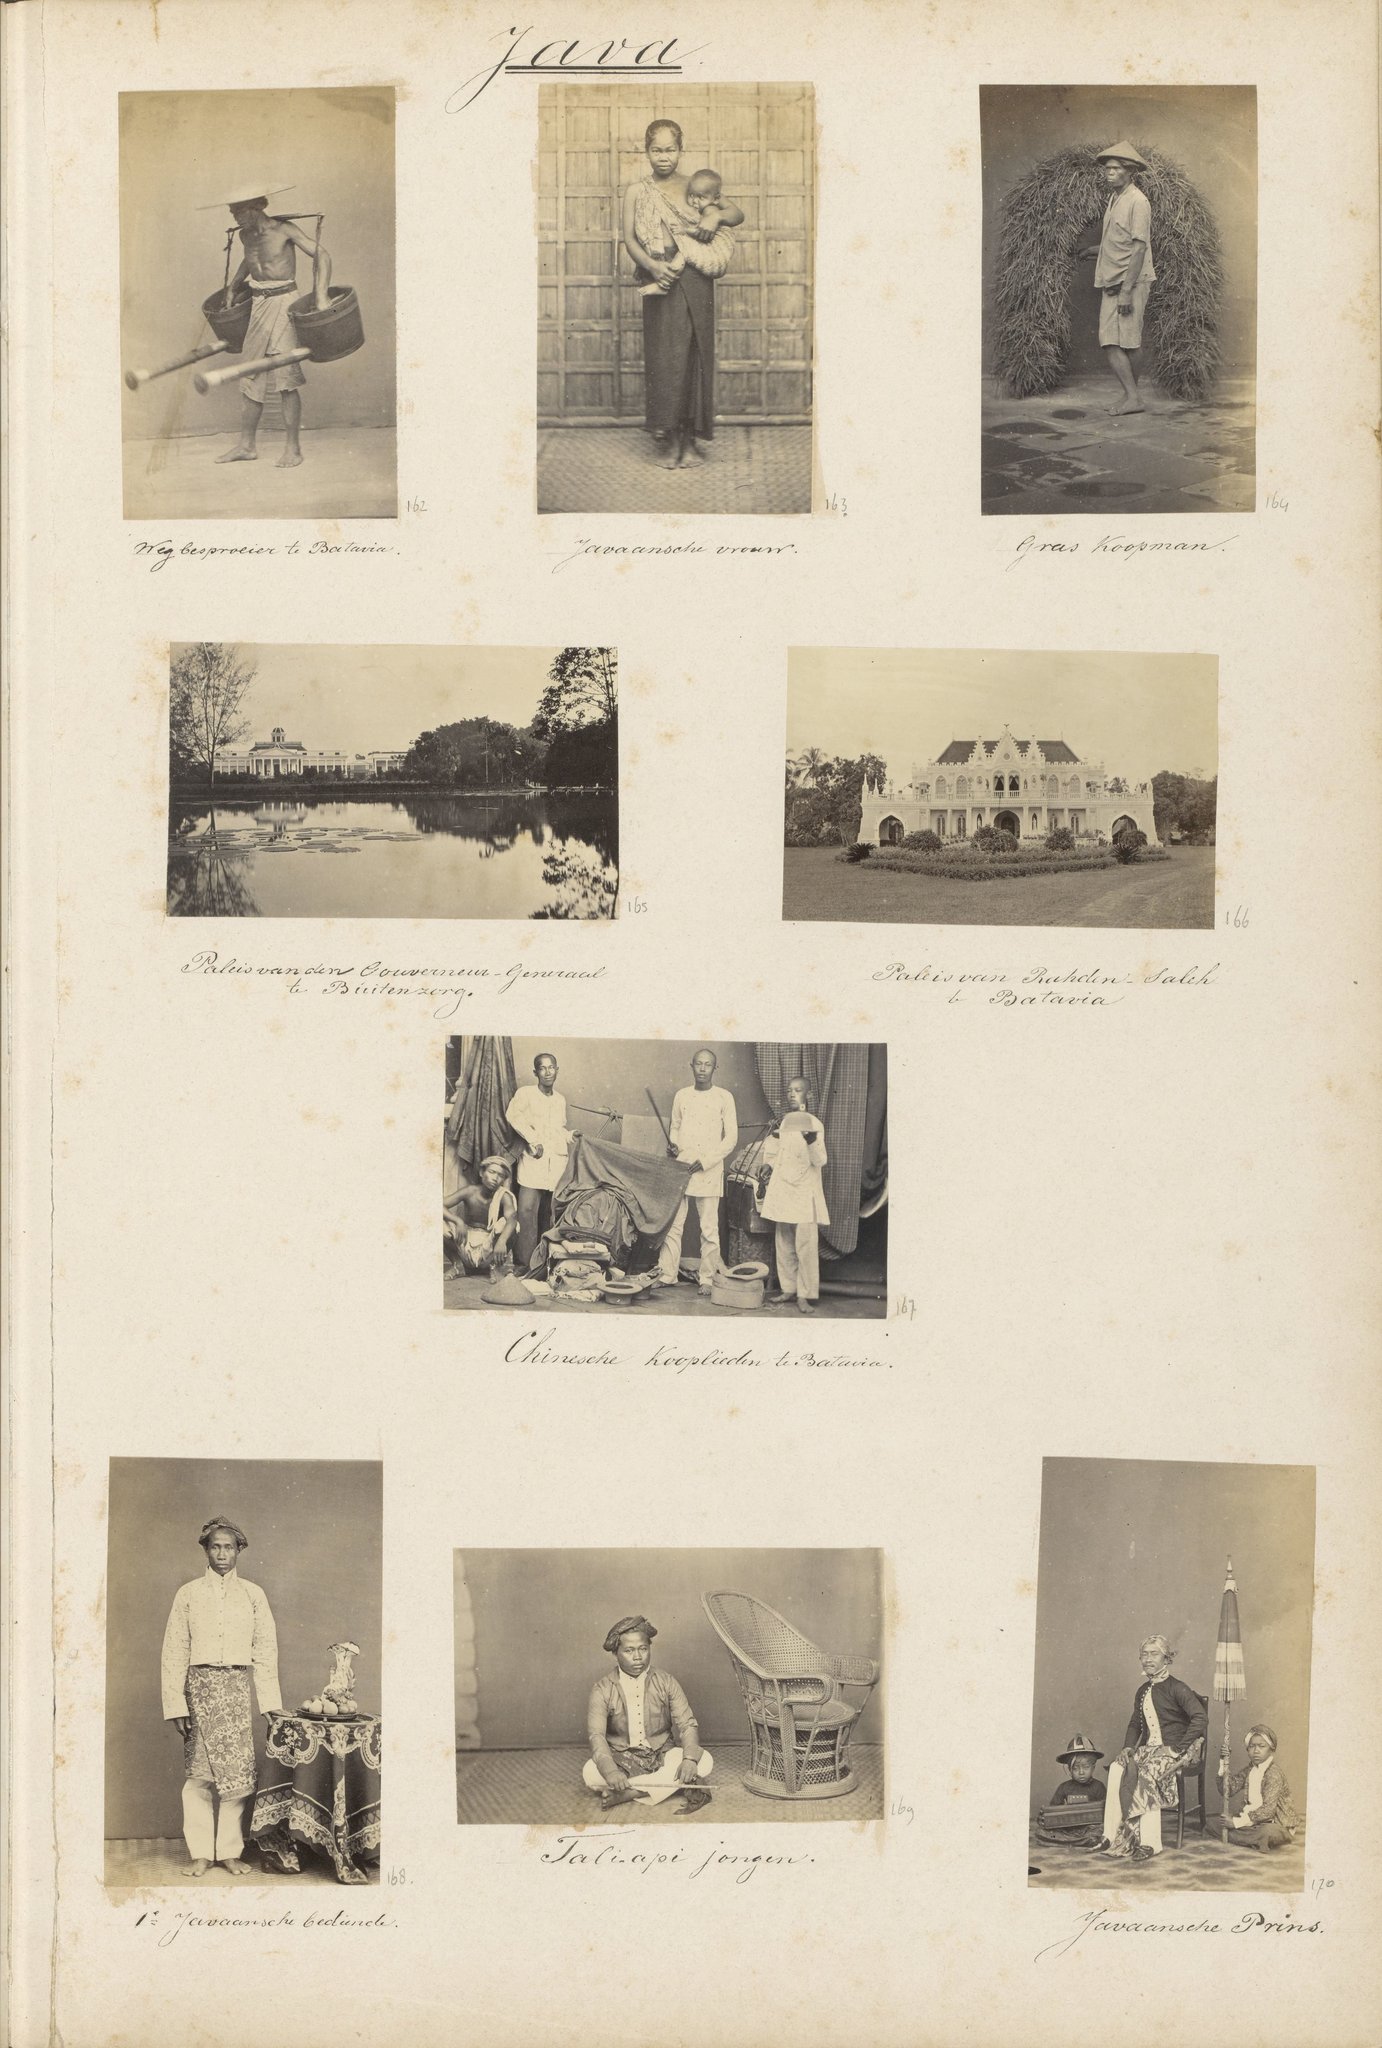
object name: photograph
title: Gezicht op het paleis van schilder Raden Saleh te Batavia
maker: Anonymous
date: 1870-1880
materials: paper, photographic support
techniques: albumen print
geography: batavia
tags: palace, batavia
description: Onderdeel van Fotoalbum van Robert Daniel Crommelin (1841-1907).